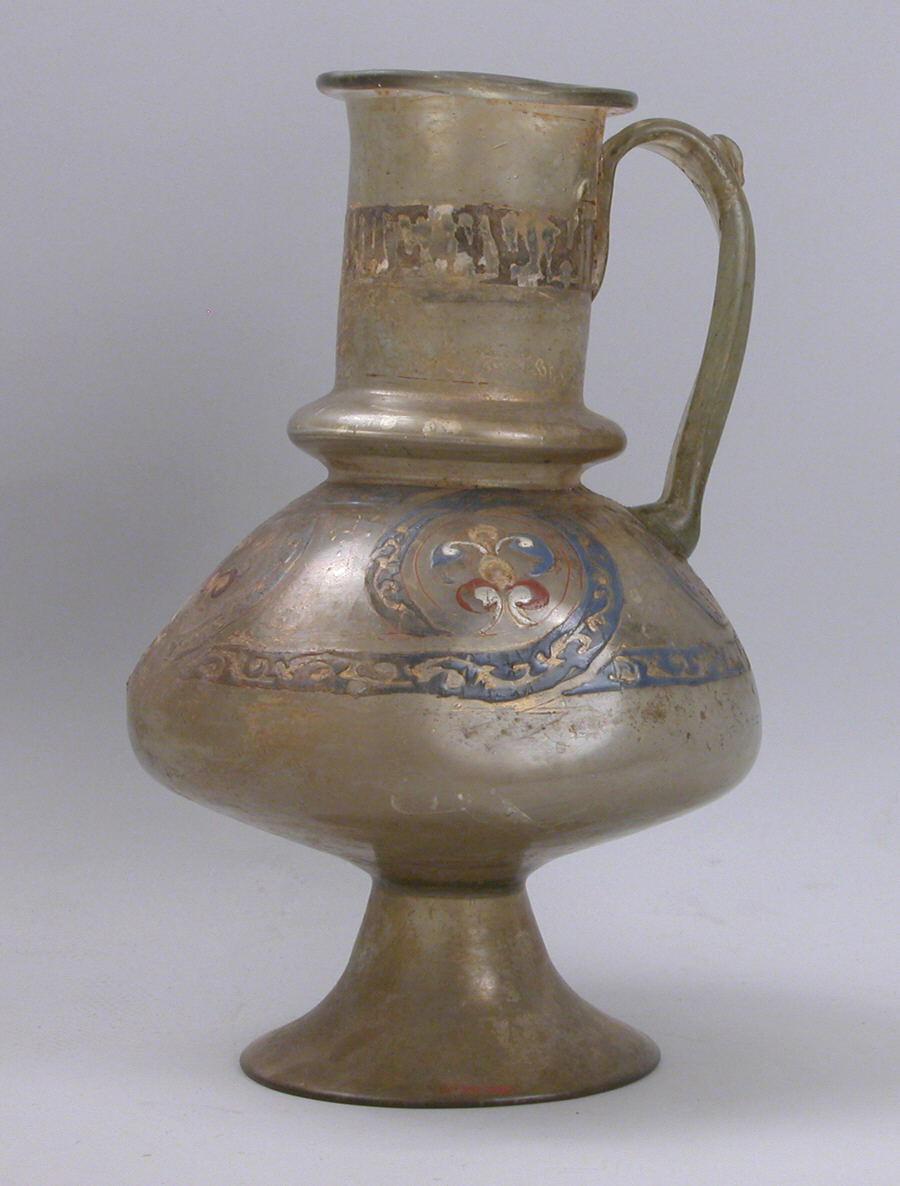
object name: ewer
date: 1301-1400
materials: glass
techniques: enamel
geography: syria